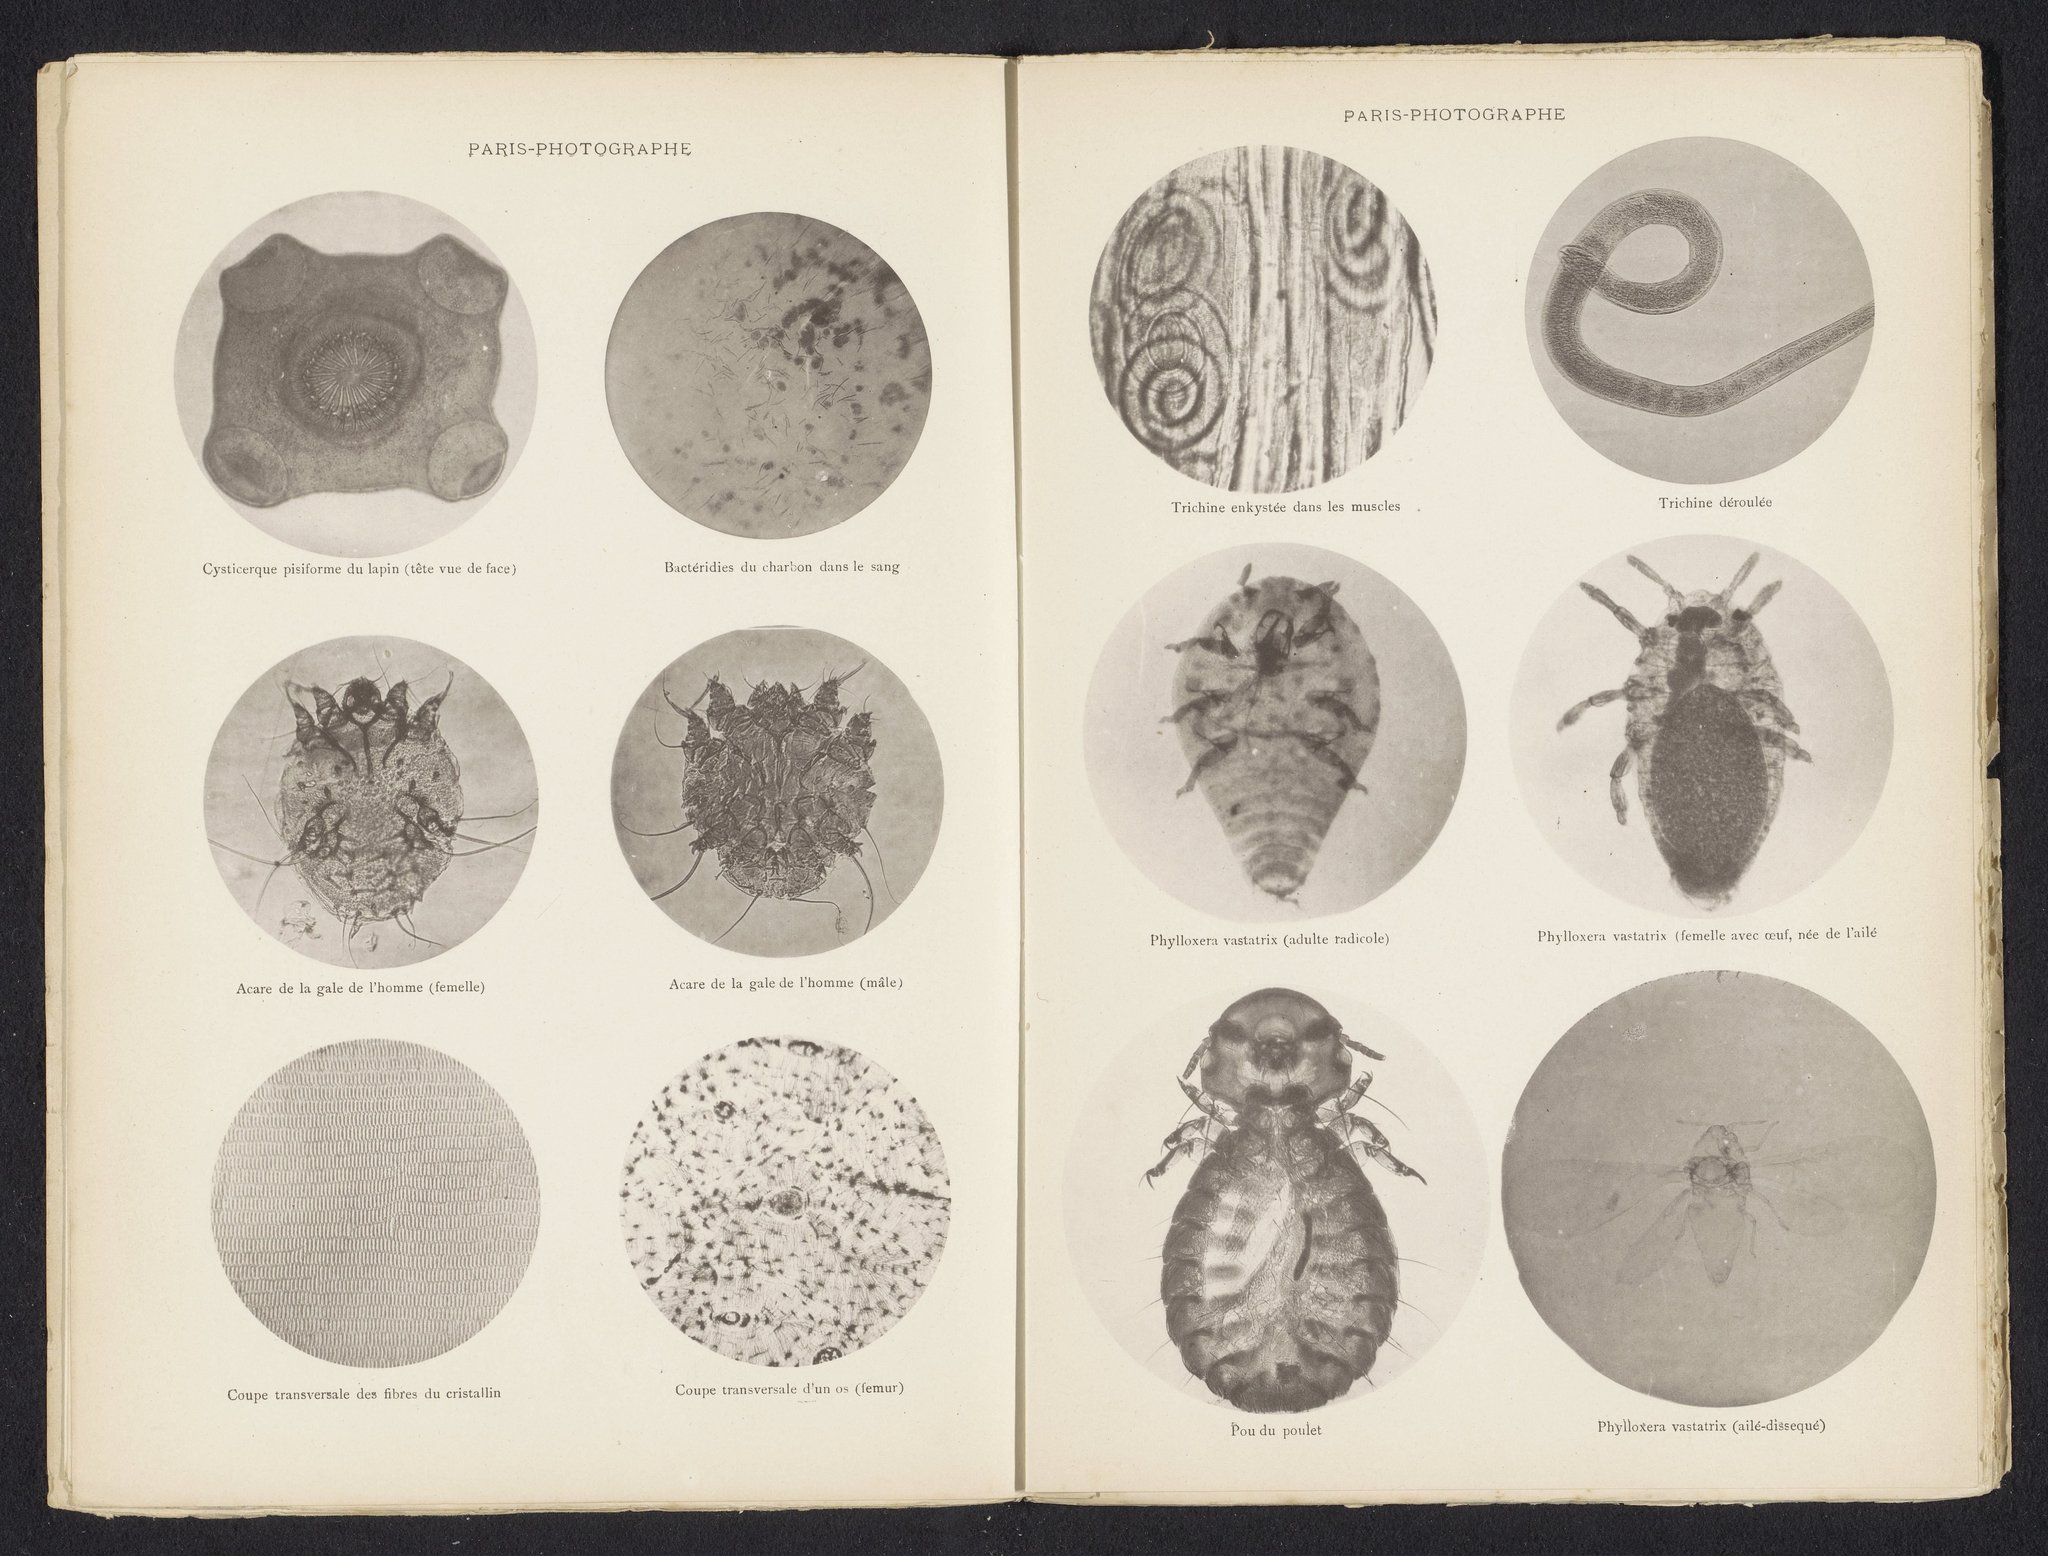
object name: photomechanical print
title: Overzicht van microscopische vergrotingen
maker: Anonymous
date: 1881-1891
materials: paper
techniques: photograph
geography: france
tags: unicellular animals, bacteria, bacilli, bones of the legs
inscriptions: inscription: ‘Cysticerque pisiforme (...) Coupe transversale d'un os (femur)’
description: Boven een cysticercus en een bacterie, midden een schurftbacterie, onder een deel van de ooglens en een deel van het dijbeen.